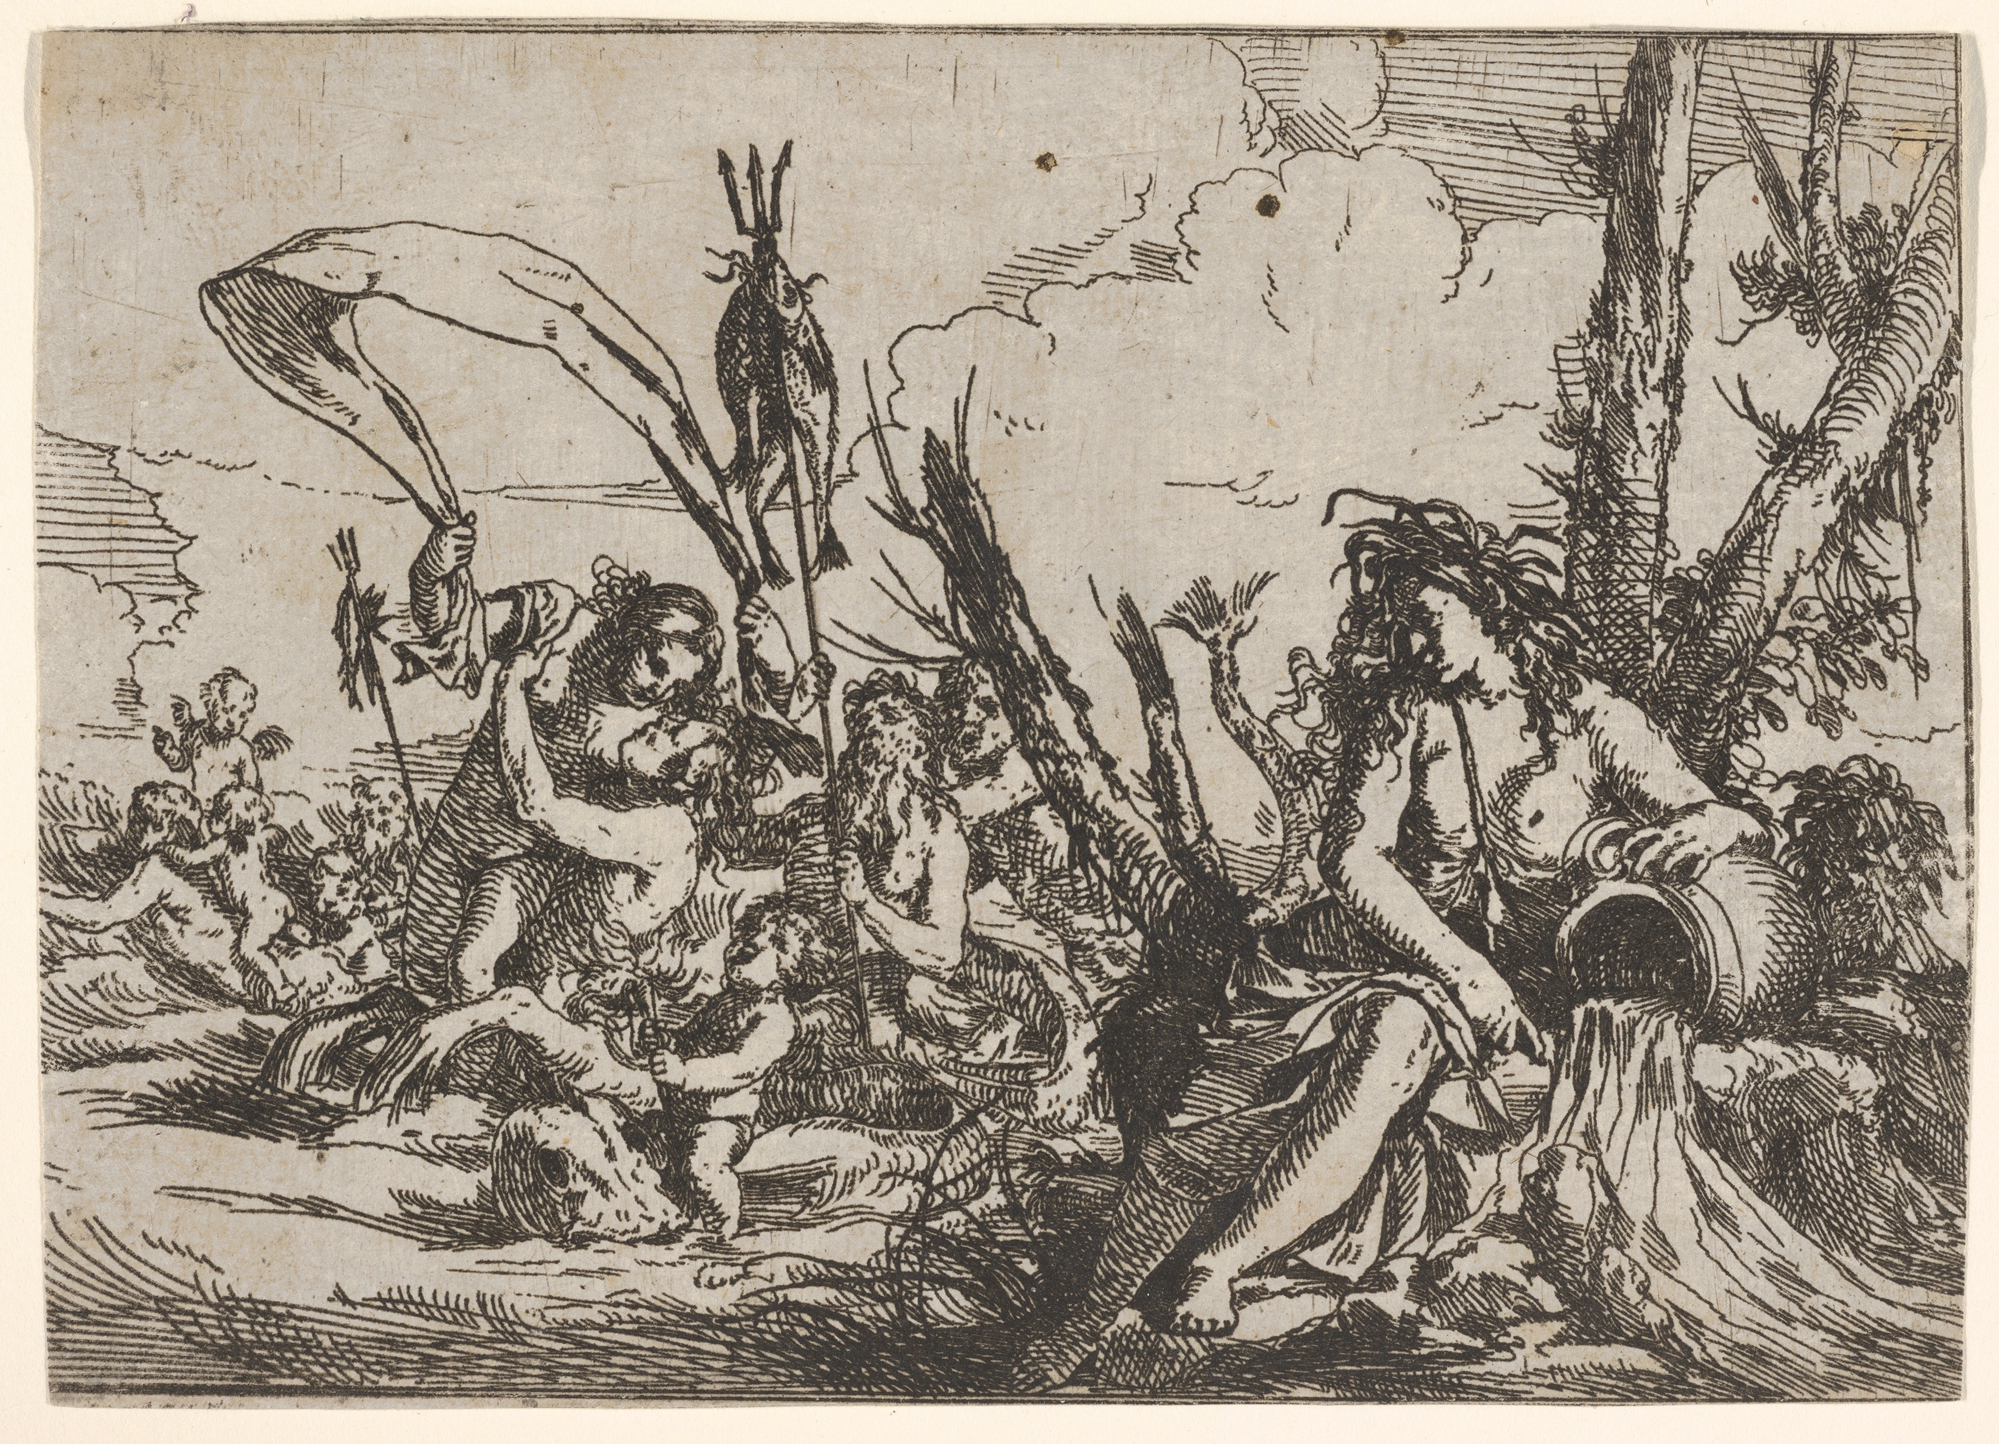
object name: print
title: Water, represented by a naiad seated at the base of a tree and resting her arm on a supine urn from which water flows, behind her a triton and other inhabitants of the sea rise from the water surface, from "The Elements"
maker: giulio carpioni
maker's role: artist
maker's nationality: italian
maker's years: 1613-1678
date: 1640-1660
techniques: etching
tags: triton,nymphs,urns